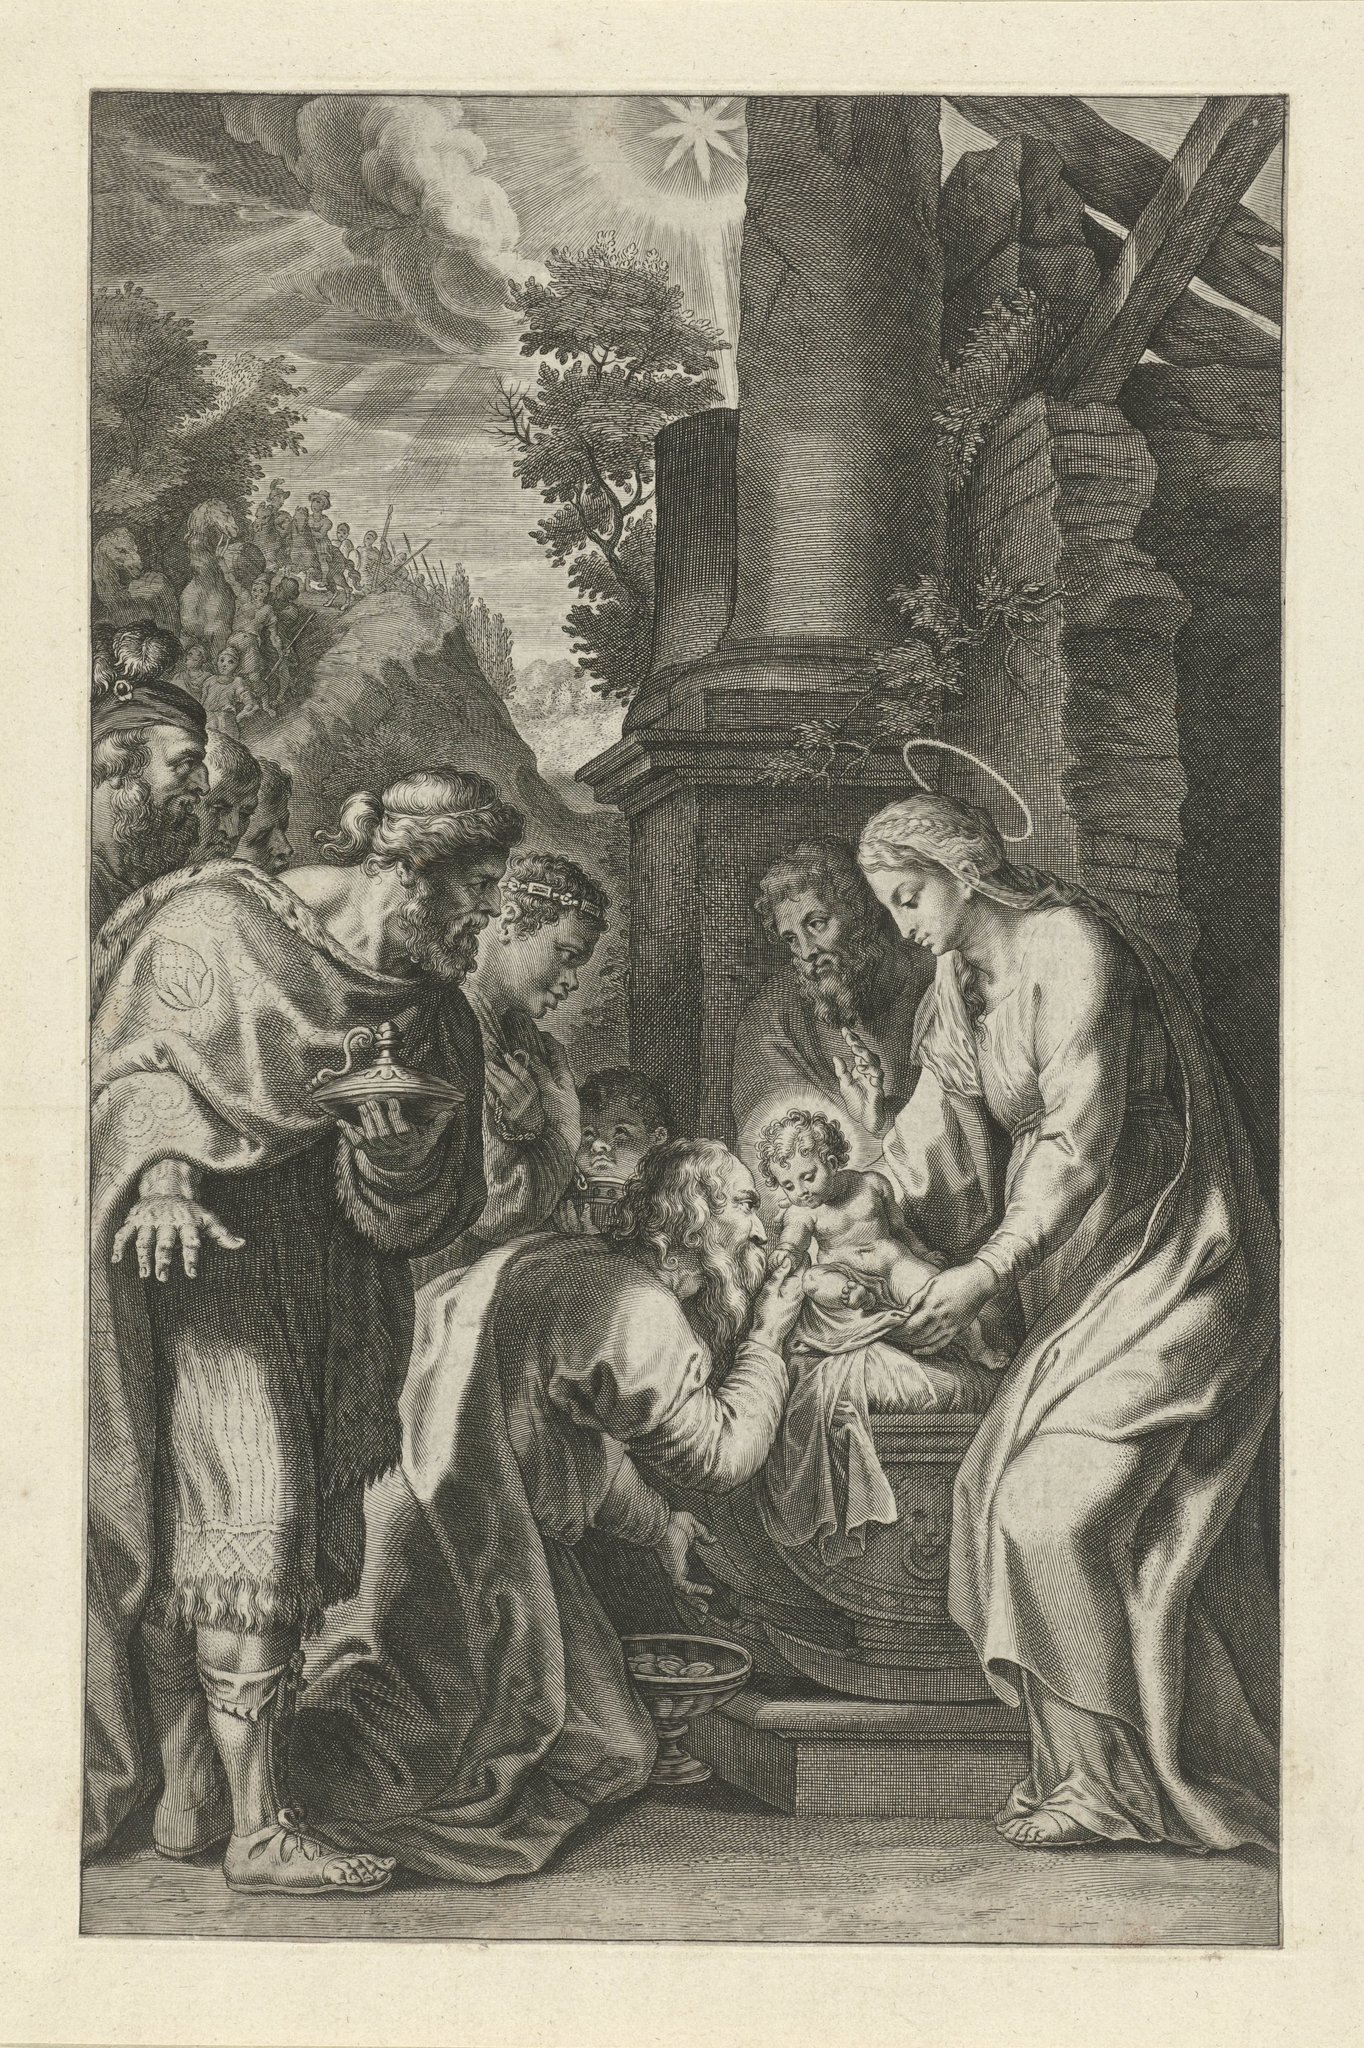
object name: print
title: Scènes uit het Oude en Nieuwe Testament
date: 1612-1616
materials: paper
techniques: engraving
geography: antwerp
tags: adoration of the kings: the wise men present their gifts to the christ-child (gold, frankincense and myrrh)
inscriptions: collector's mark: Lugt 240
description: Maria en Jozef tonen het Christuskind aan de drie wijzen. De drie bieden het kind hun geschenken aan. Op de achtergrond leden van hun gevolg. In de verte schijnt de ster die hen naar de stal in Bethlehem heeft geleid. De prent is deel van een serie met scènes uit het Oude en Nieuwe Testament.